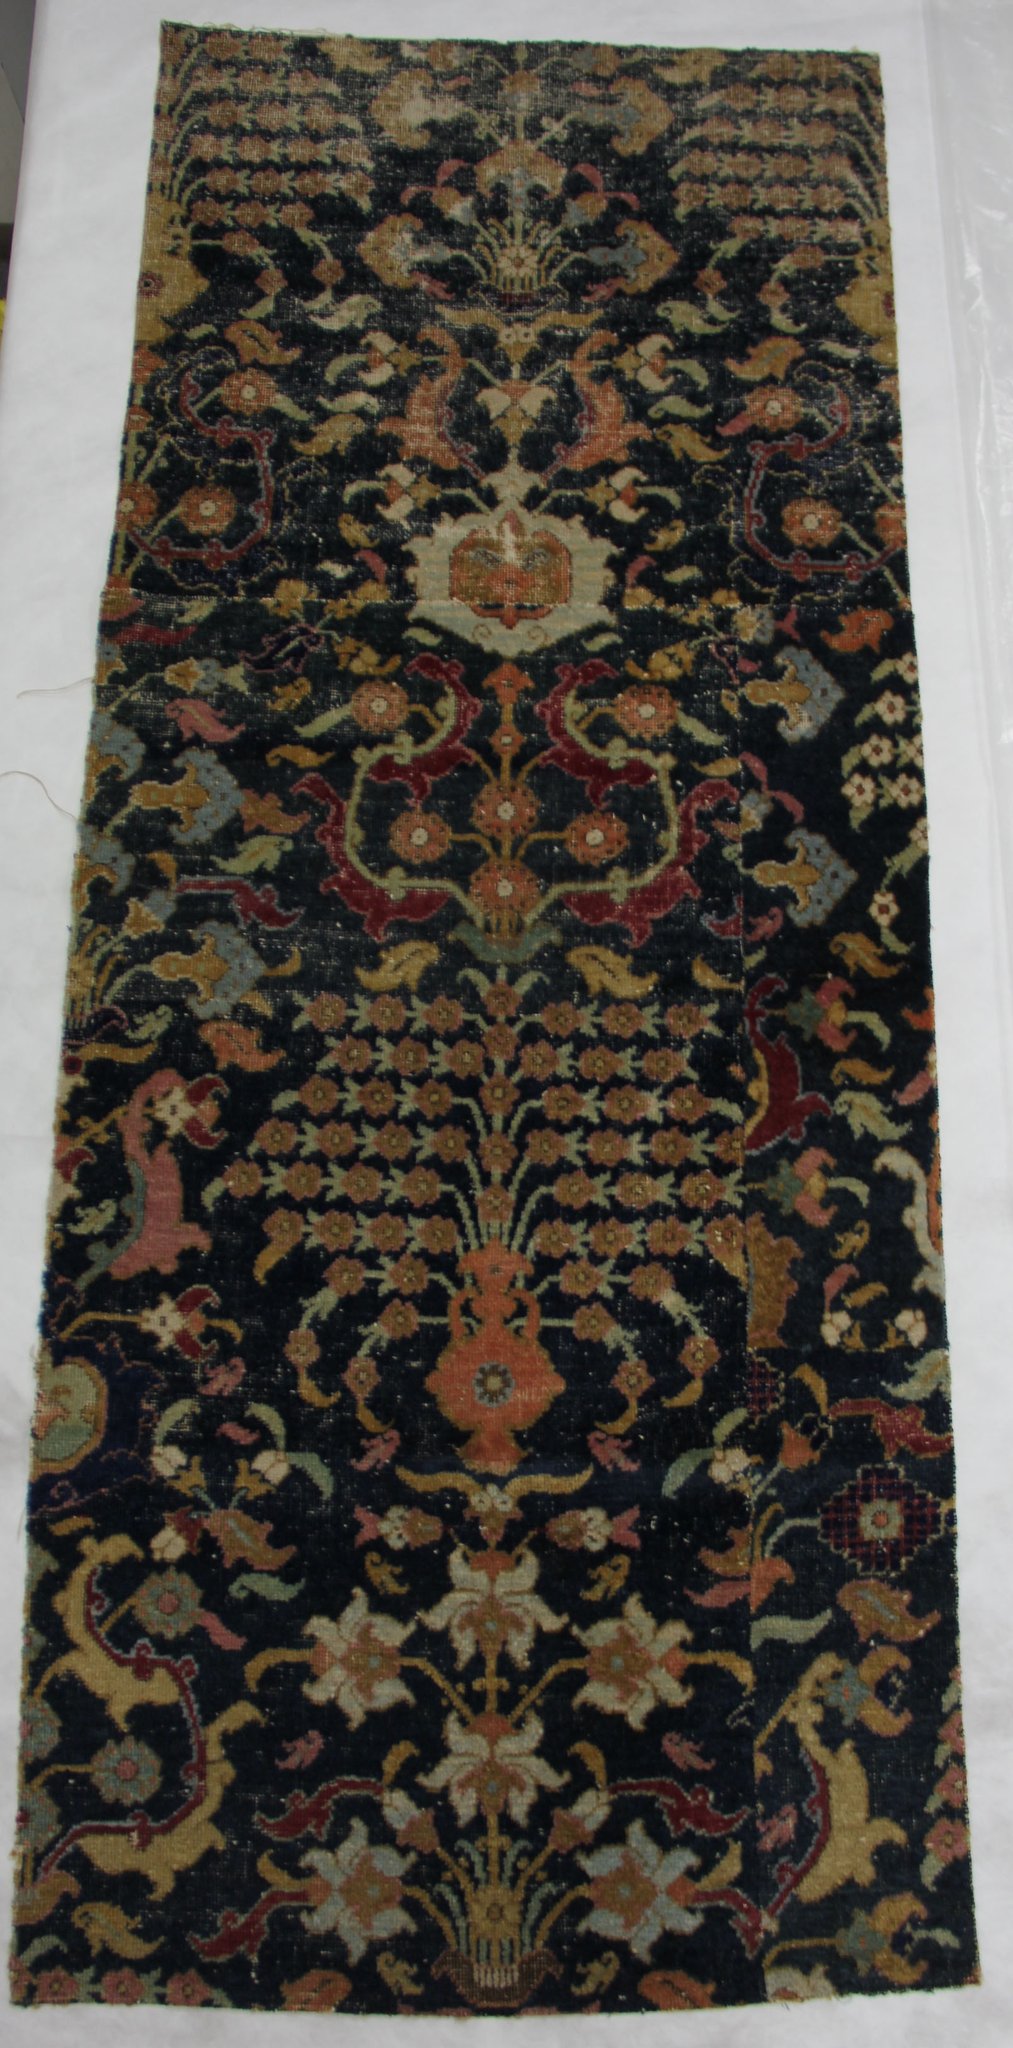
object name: carpet fragment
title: Shrub Carpet Fragment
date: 1601-1700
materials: cotton, wool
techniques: asymmetrically knotted pile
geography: iran